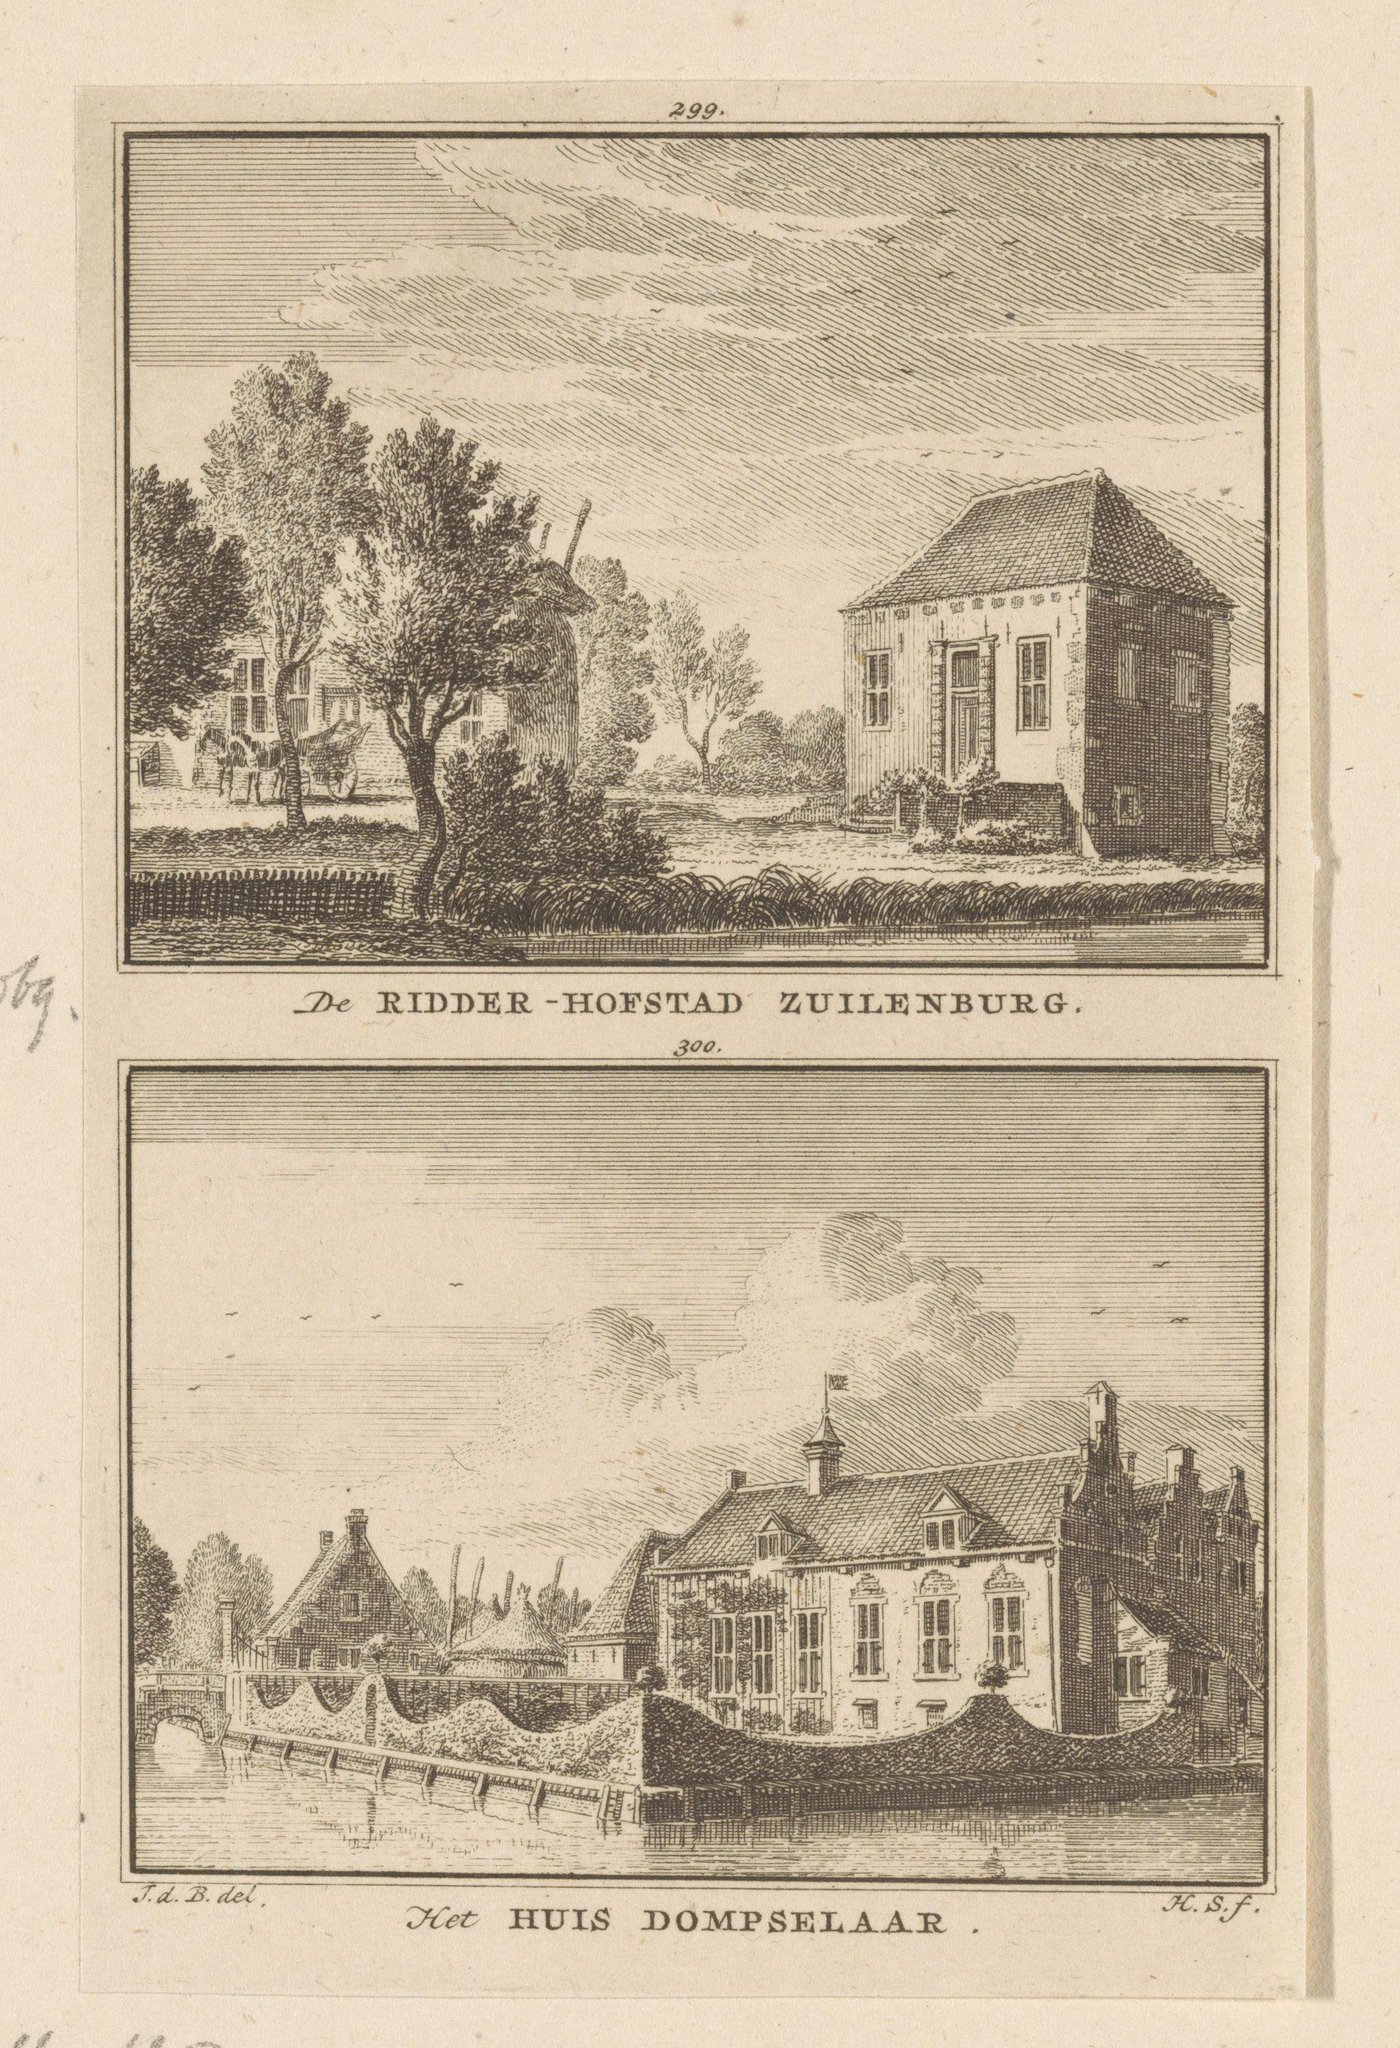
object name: print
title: De ridder-hofstad Zuilenburg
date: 1773-1792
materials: paper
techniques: engraving, etching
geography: haarlem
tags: castle, farm (building)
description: Prent ook gebruikt in: Het verheerlykt Nederland of kabinet van hedendaagsche gezigten van steden, dorpen (…). 9 delen. Amsterdam: Isaak Tirion en weduwe Isaak Tirion, 1745-1774, dl. 7, 8 of 9 (weduwe Isaak Tirion, 1773-1774), ill. 299 en 300. Of in: Nederlandsche tafereelen; of eene keurige verzameling van negen honderd fraaije gezigten van steden, dorpen, sloten, oudheden (….). 9 delen. Amsterdam: Jan de Groot, 1792, dl. 7, 8 of 9, ill. 299 en 300. Uit welke druk het huidige exemplaar precies komt is niet na te gaan.